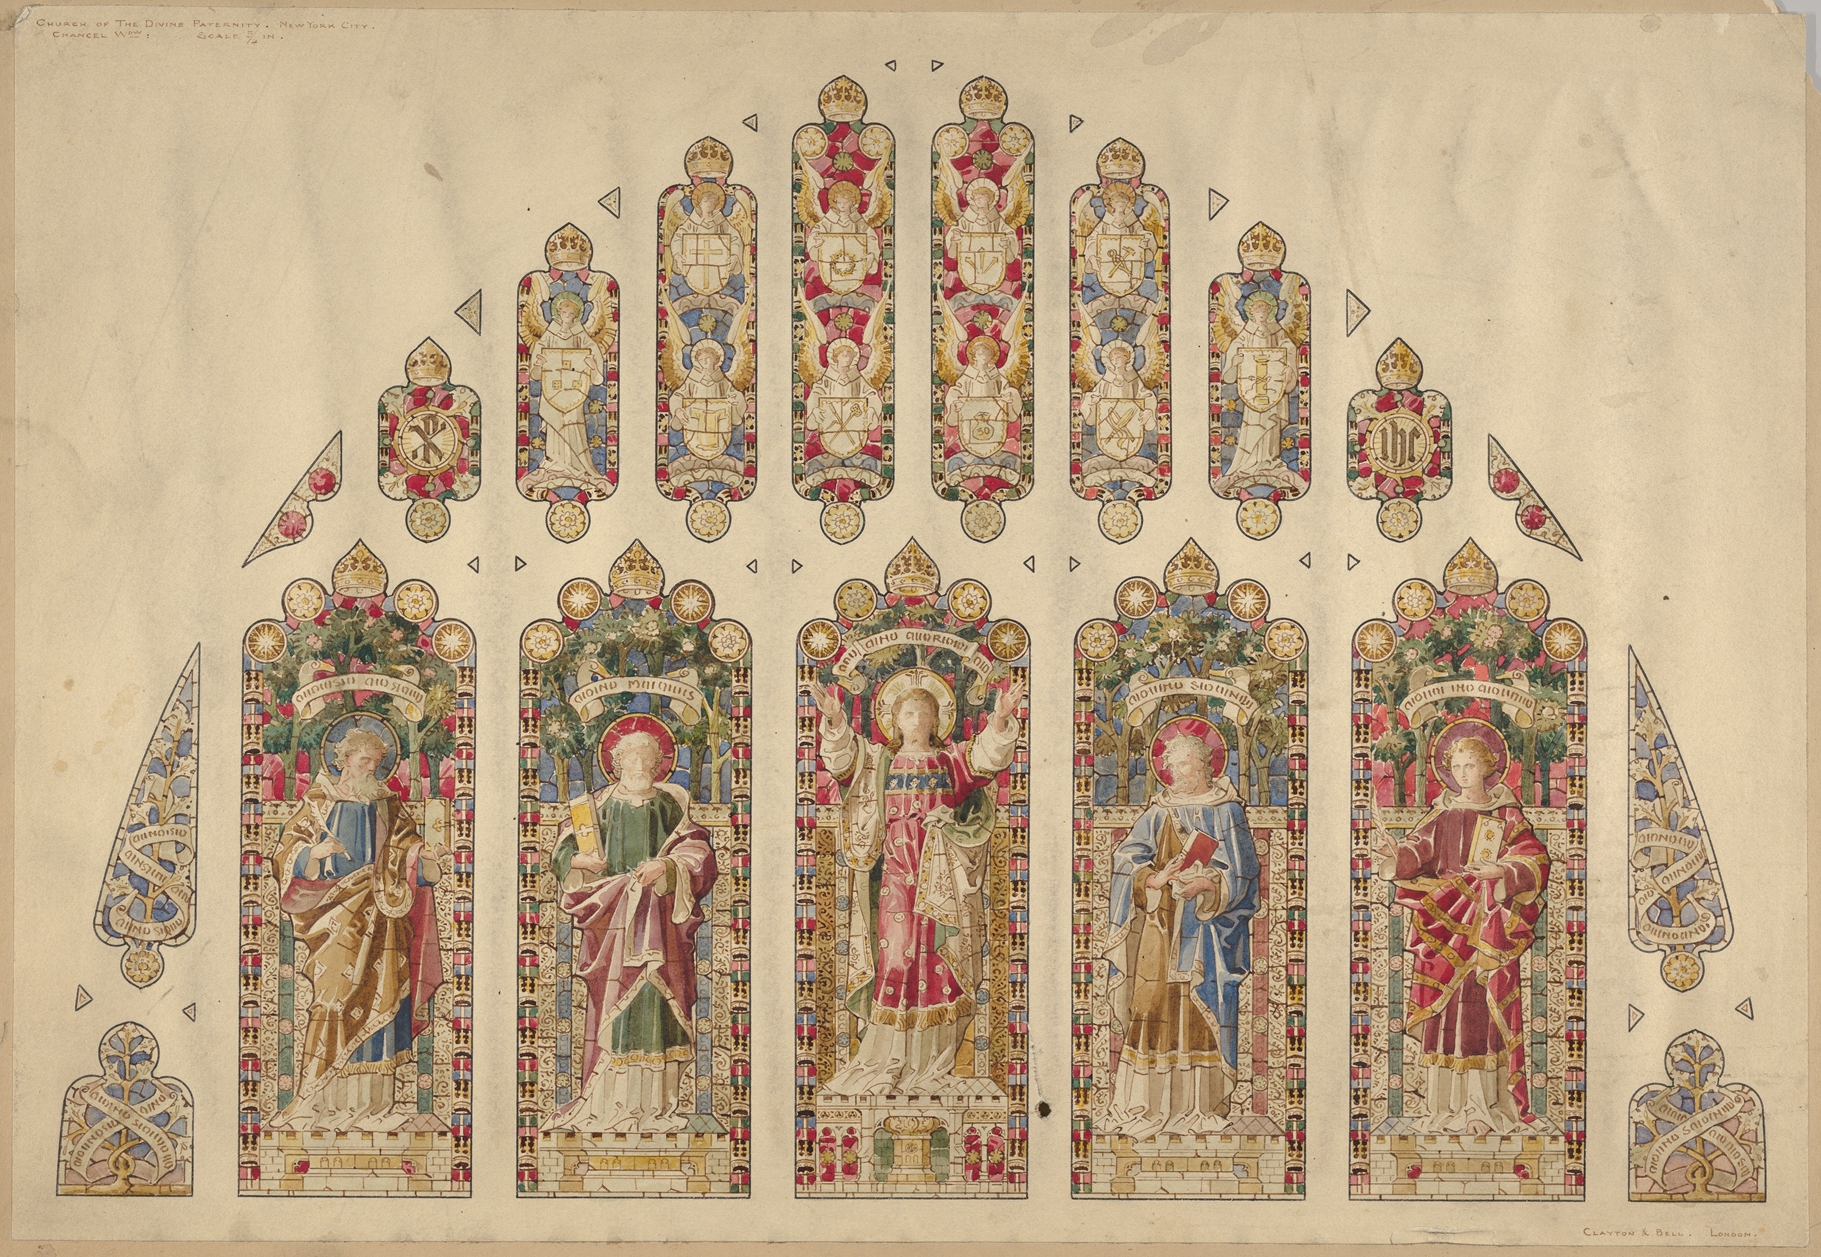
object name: drawing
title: Design for a Multi-paned Stained-glass Window, Church of the Divine Paternity, New York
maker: clayton and bell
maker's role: designer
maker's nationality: british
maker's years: 1857-1913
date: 1898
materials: ink, watercolor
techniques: pen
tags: men,christ,saints